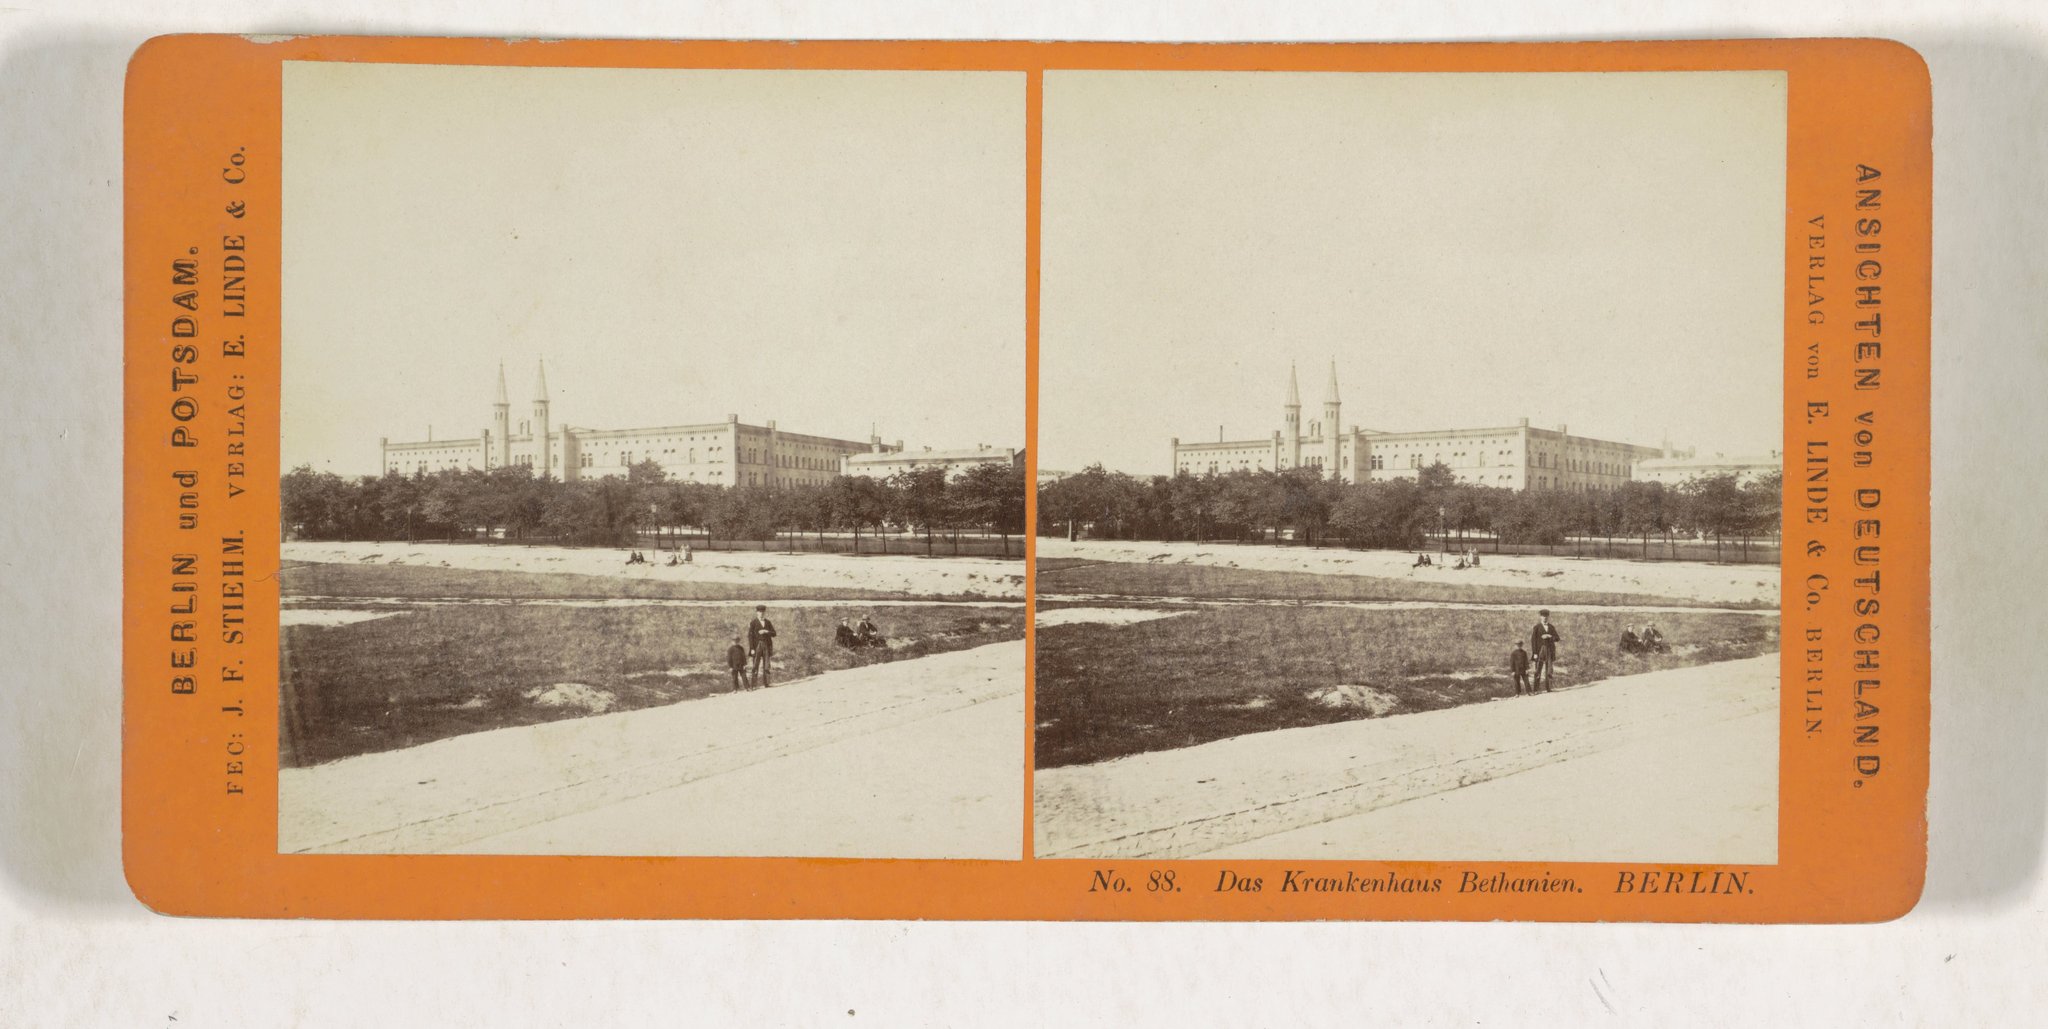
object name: stereograph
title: Ansichten von Deutschland / Berlin und Potsdam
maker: johann friedrich stiehm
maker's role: fotograaf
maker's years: 1826-1902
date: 1868-1870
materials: cardboard, paper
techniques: albumen print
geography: berlin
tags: hospital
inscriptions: number: ‘No. 88.’